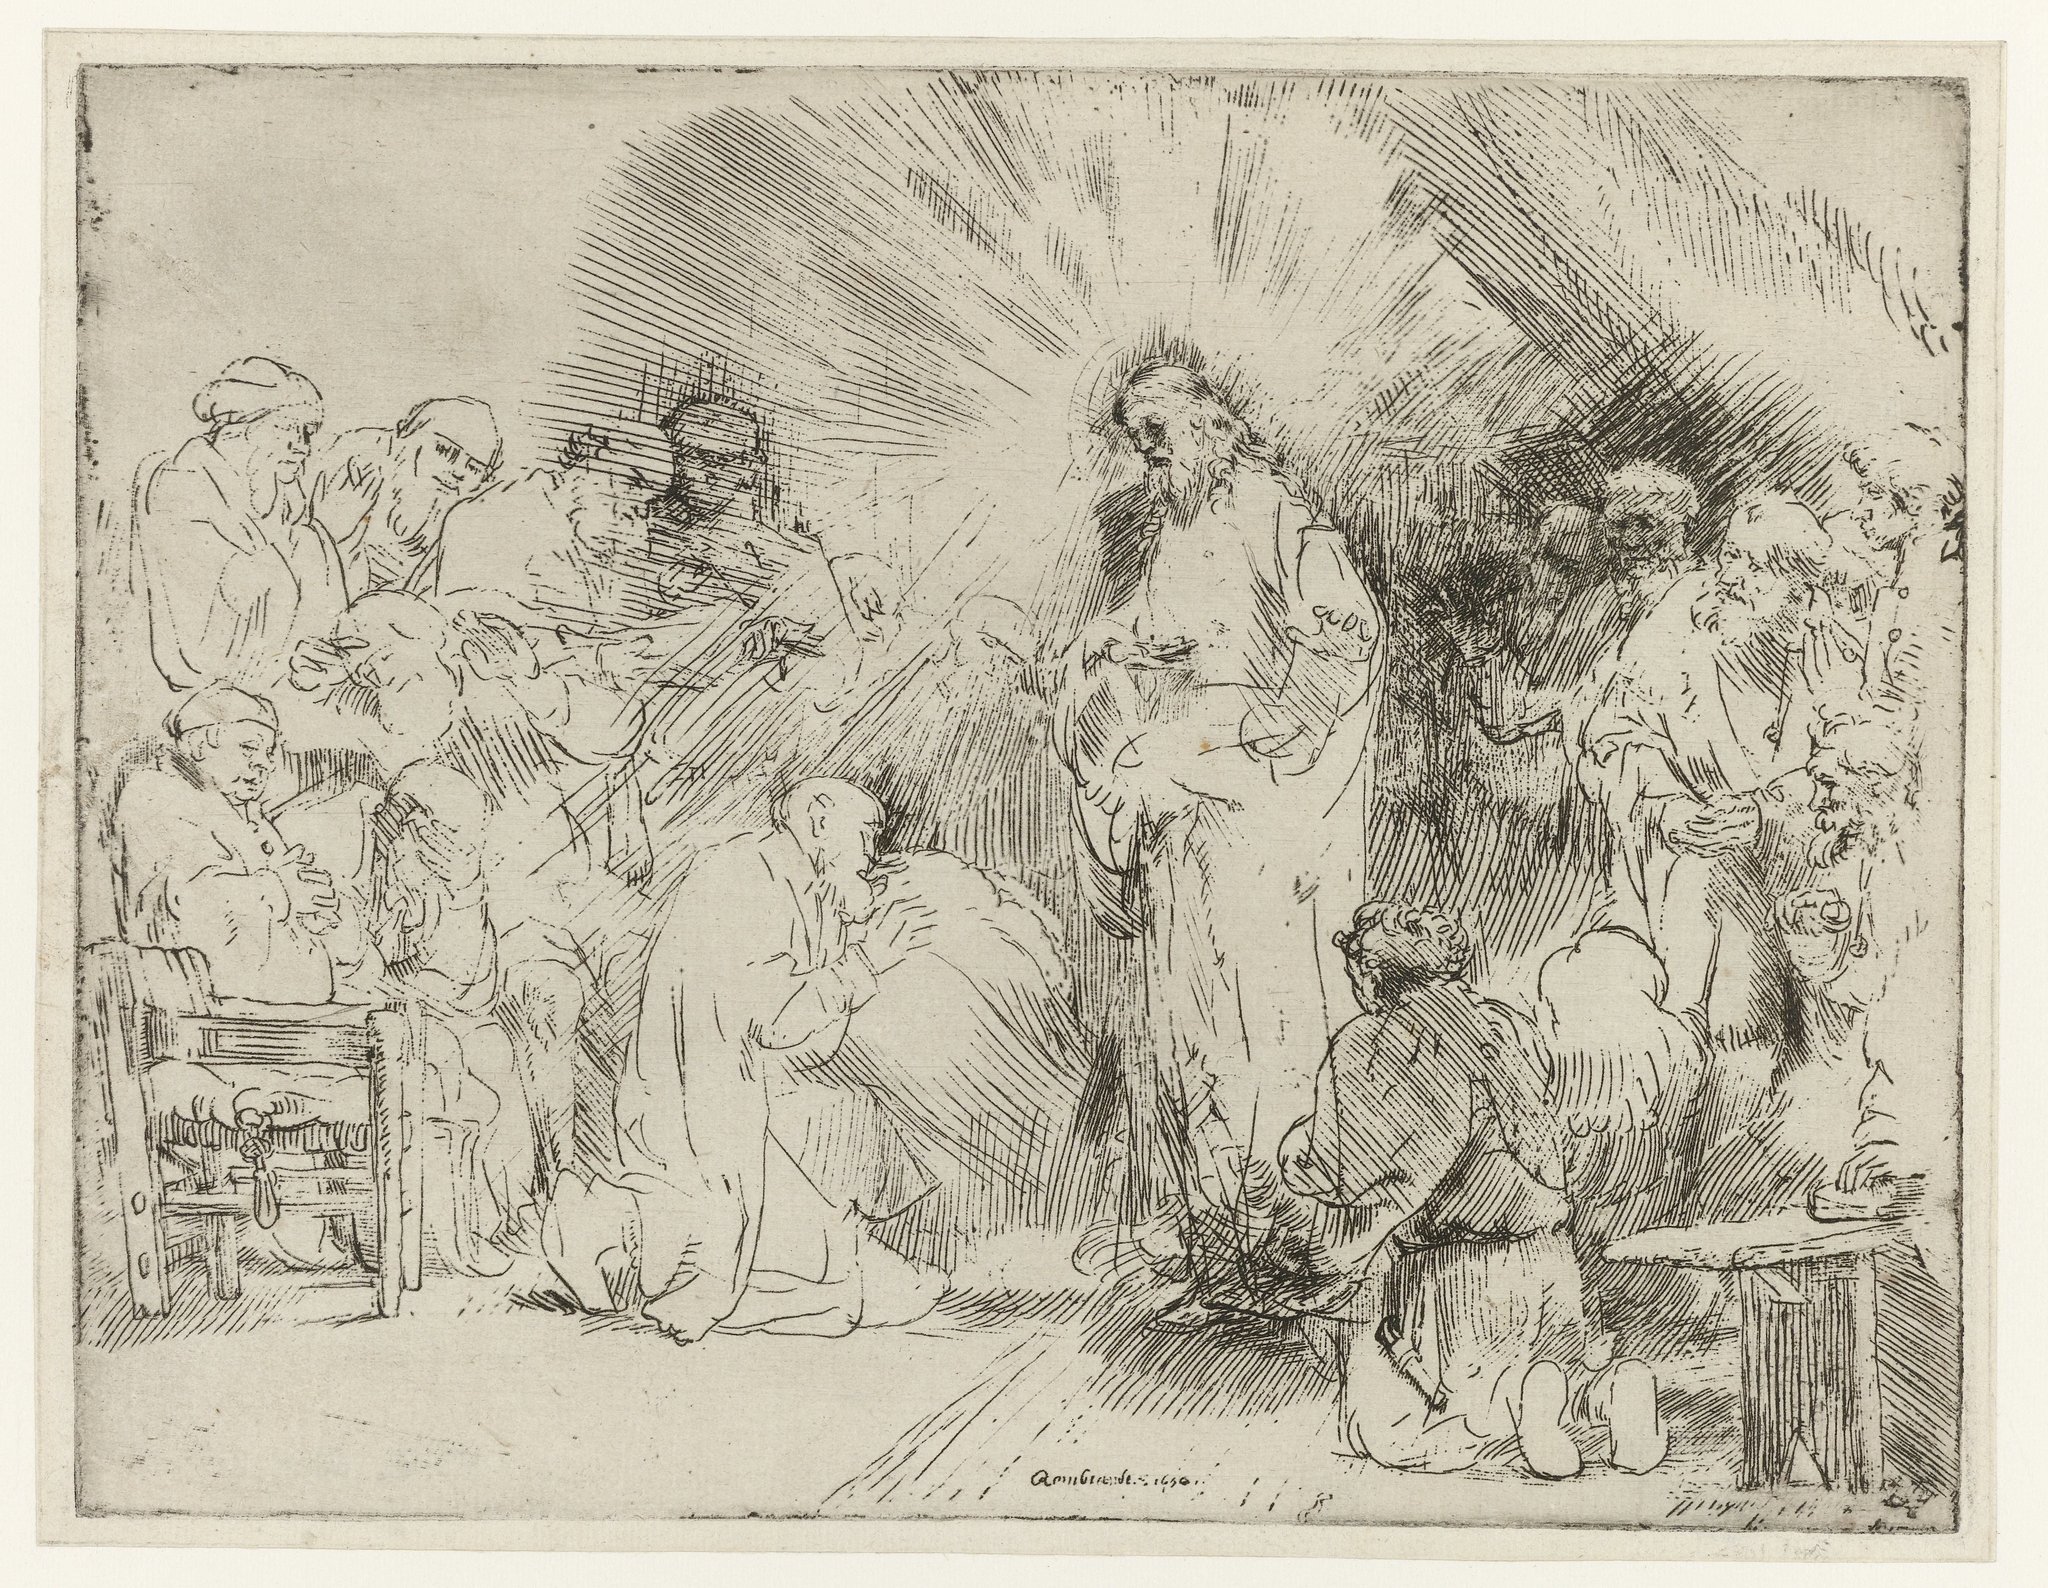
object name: print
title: Christ Appearing to the Apostles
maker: rembrandt van rijn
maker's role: draughtsman, painter, print maker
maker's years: 1606-1669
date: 1656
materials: paper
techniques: etching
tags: christ appears to the apostles (gathered behind locked doors)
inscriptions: collector's mark: Lugt 240, signature and date: ‘Rembrandt f.1656’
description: Rembrandt delighted in varying the extent to which he worked out a scene. In some instances, this was very detailed, almost painterly, and in others he limited himself to little more than outlines. Here Christ appears to the apostles after his resurrection. The minimal elaboration reinforces the impression of a momentous event bathed in heavenly light.